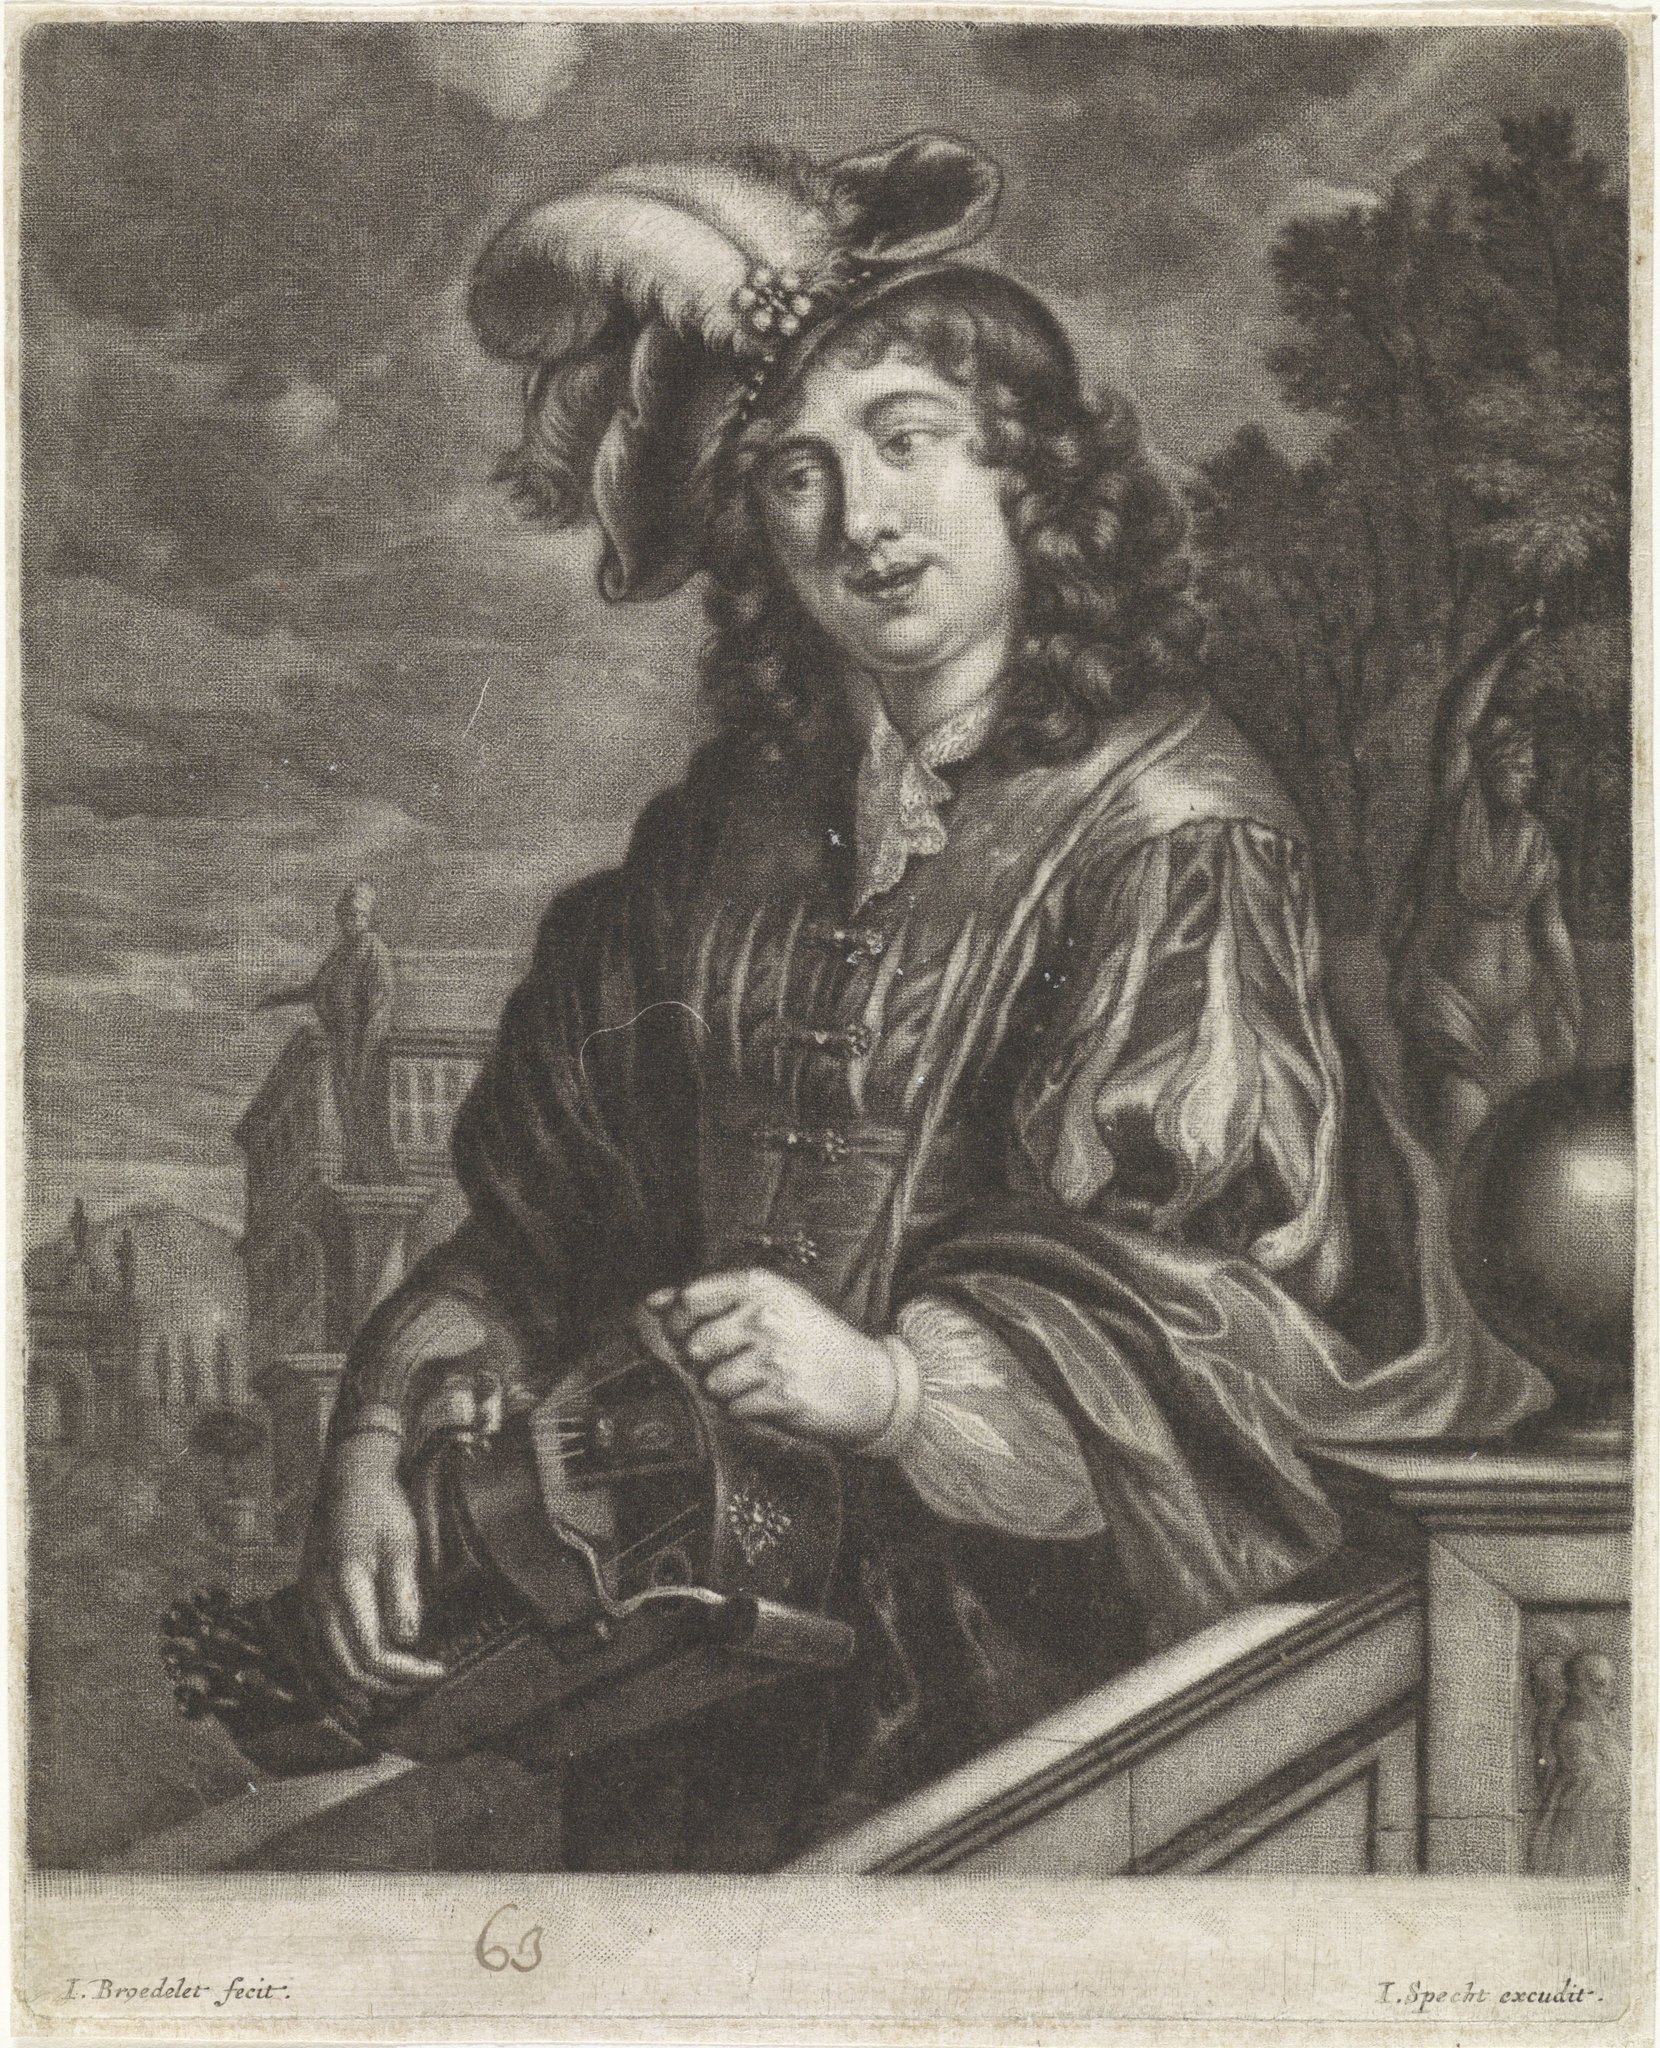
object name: print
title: Lierdraaier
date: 1690-1700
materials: paper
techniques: mezzotint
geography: utrecht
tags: lyre, cithara, psaltery, garden, head-gear: hat (+ men's clothes)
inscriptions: collector's mark: Lugt 2228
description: Op een trap in een tuin met klassieke beelden staat een lierdraaier. Hij draagt een baret met veren.